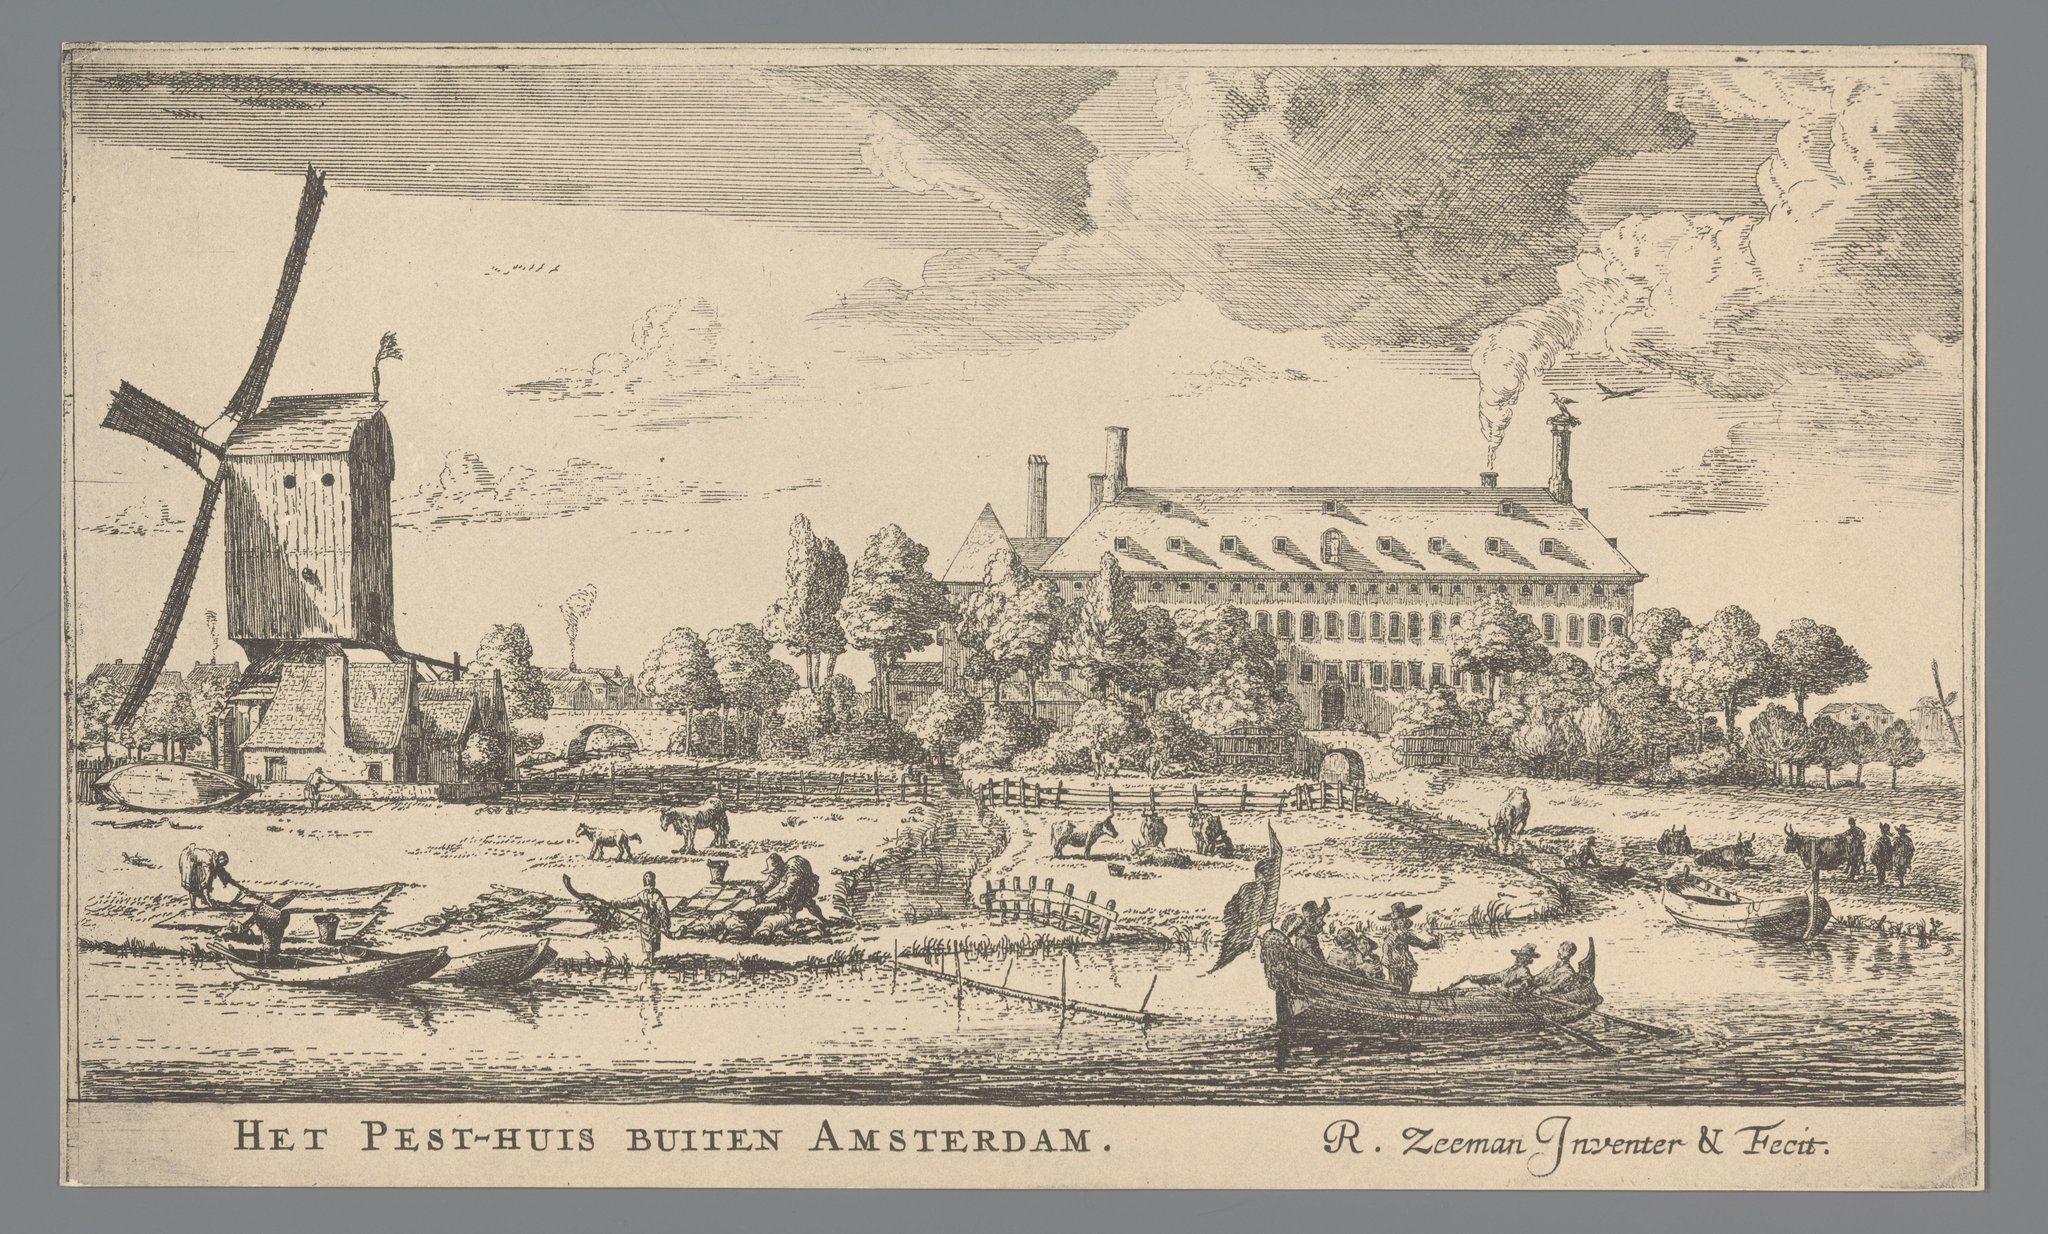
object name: photomechanical print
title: Reproductie van de prent Pesthuis buiten Amsterdam van Reinier Nooms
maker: Anonymous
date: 1908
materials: paper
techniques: photograph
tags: windmill in landscape, quarantine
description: Reproductie uit: Afbeeldingen naar belangrijke prenten en teekeningen in het Rijksprentenkabinet. Amsterdam: W. Versluys, 1908.